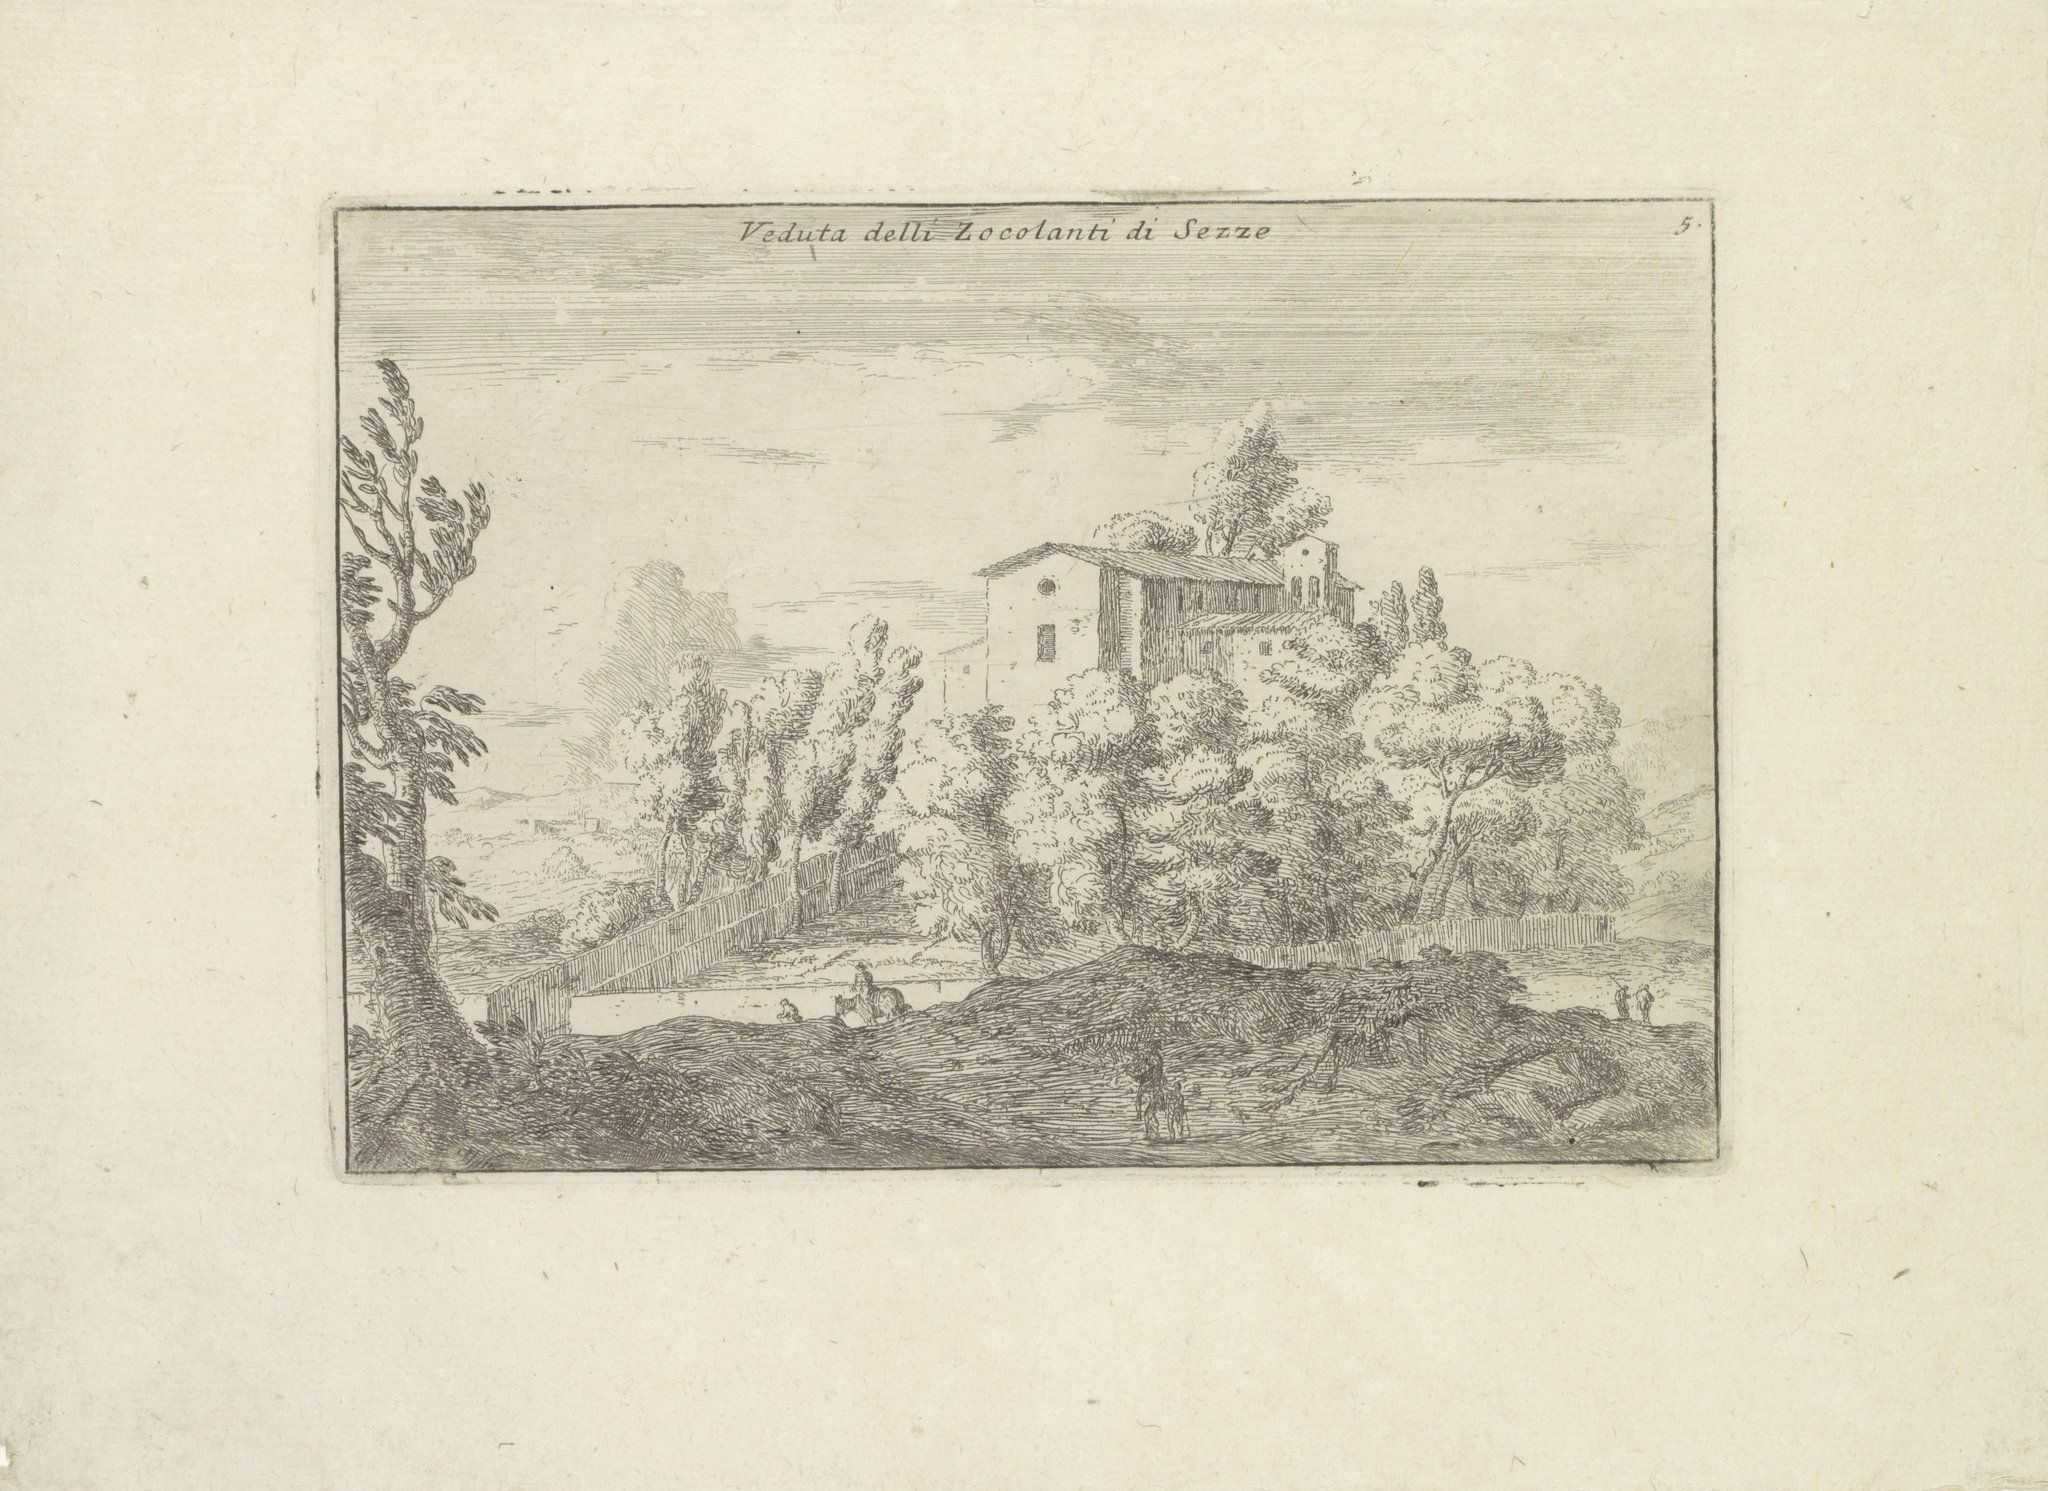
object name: print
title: Varie Vedute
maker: paolo anesi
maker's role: print maker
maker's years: 1700-1761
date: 1725-1825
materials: paper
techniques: etching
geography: rome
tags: city-view, and landscape with man-made constructions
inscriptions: collector's mark: Lugt 2760, collector's mark: Lugt 2228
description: Landschap met een kerk omgeven door bomen, in de omgeving van Rome. Midden boven de titel. Genummerd rechtsboven: 5.